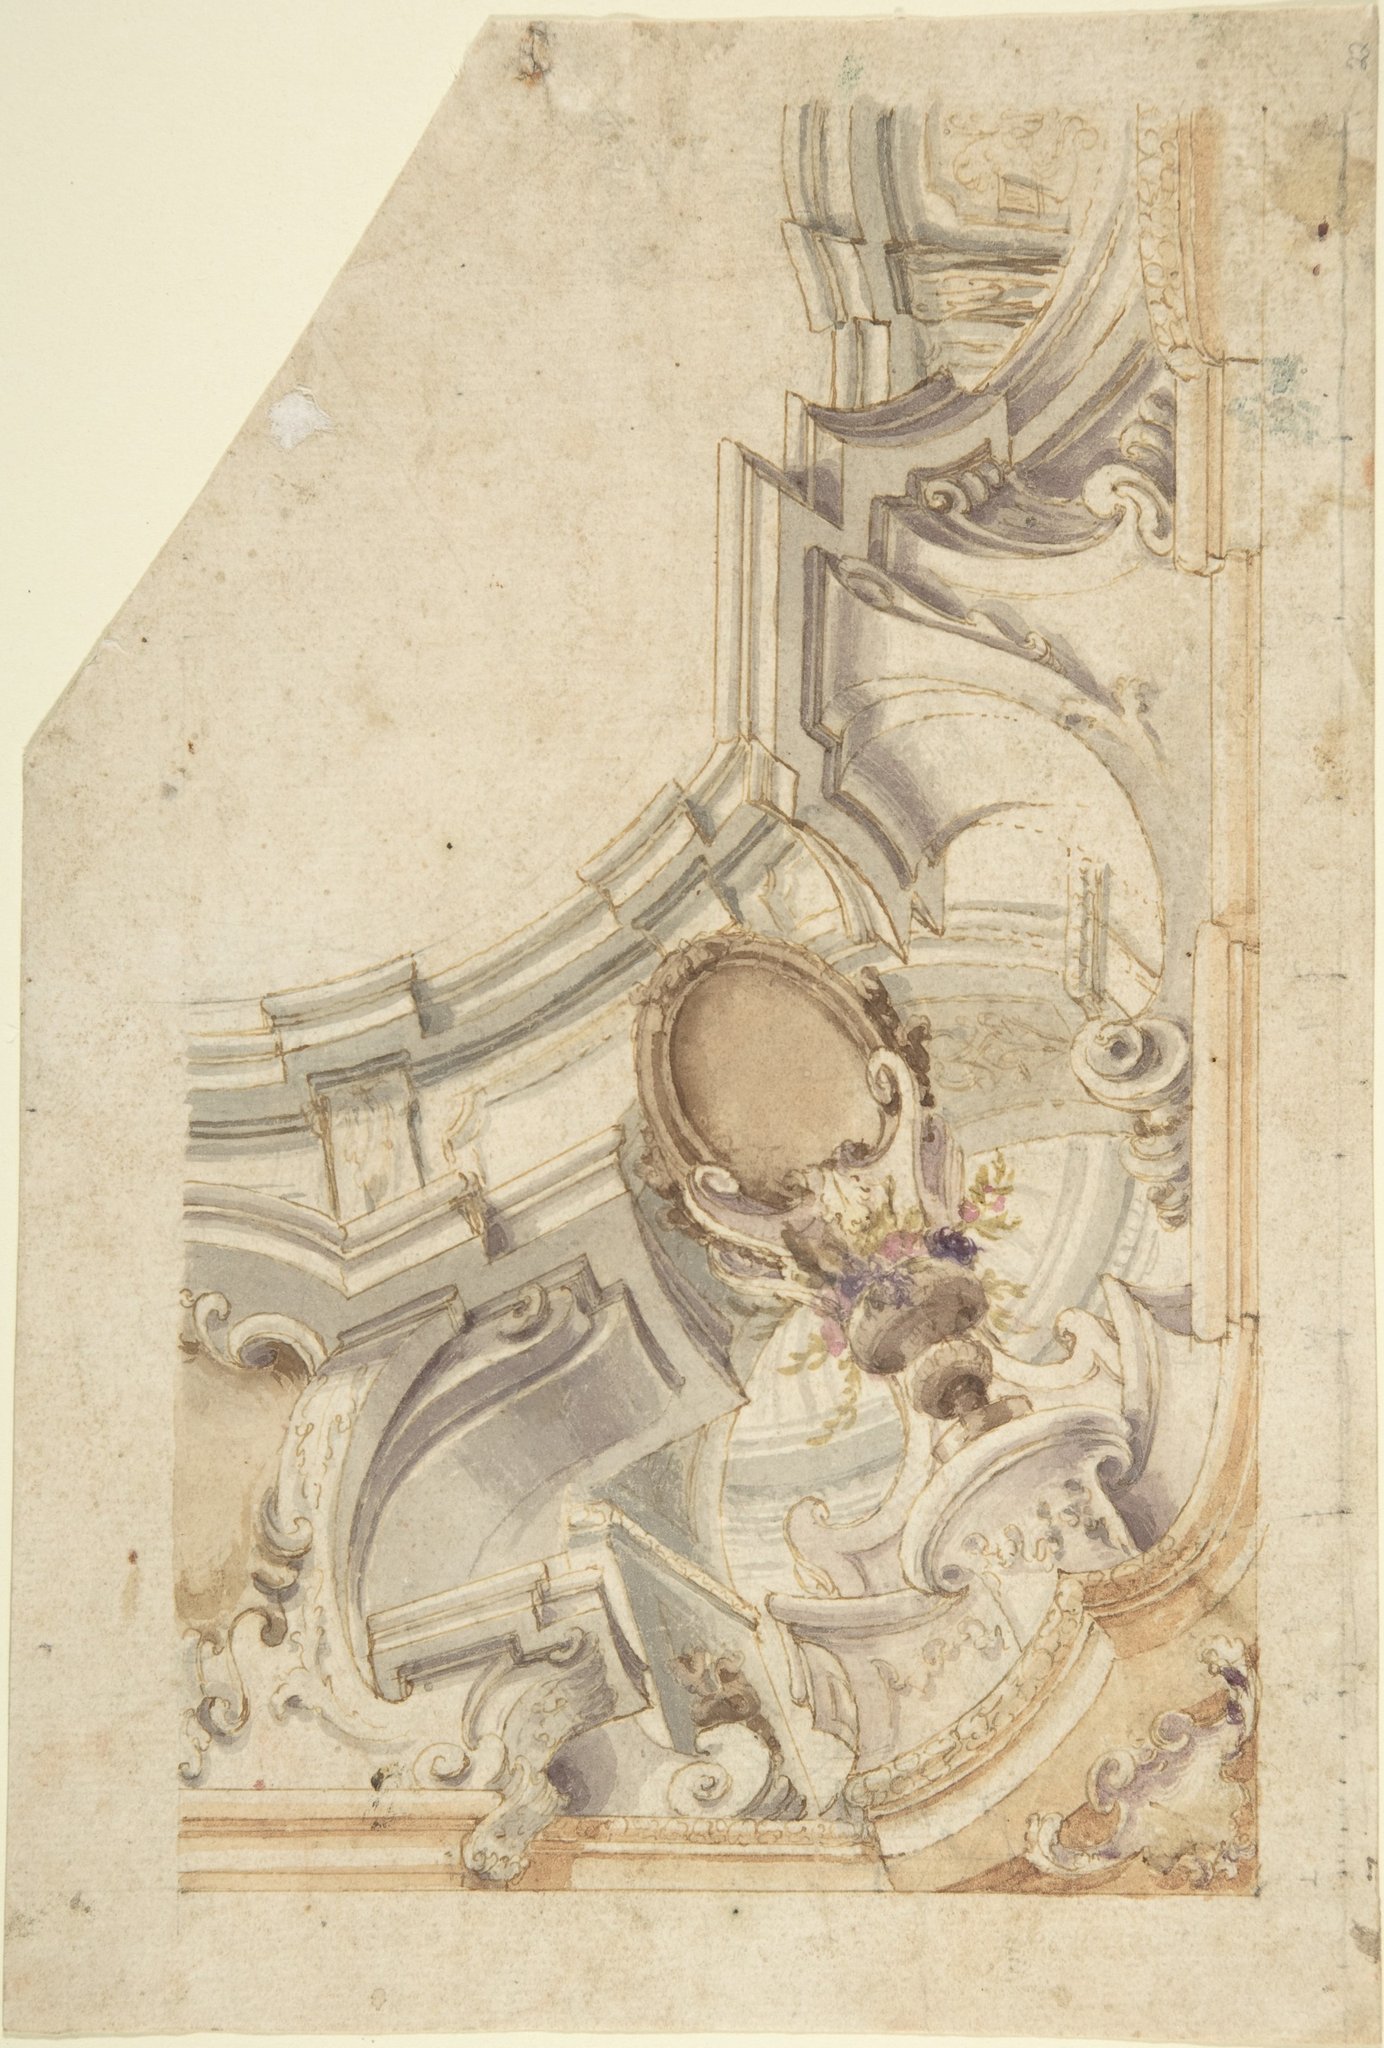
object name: drawing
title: Design for the Corner of a Cove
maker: anonymous, italian, piedmontese, 18th century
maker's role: artist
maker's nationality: italian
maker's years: 1700-1800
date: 1700-1780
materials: ink, drawing material, watercolor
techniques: brush, pen, wash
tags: flowers,vases